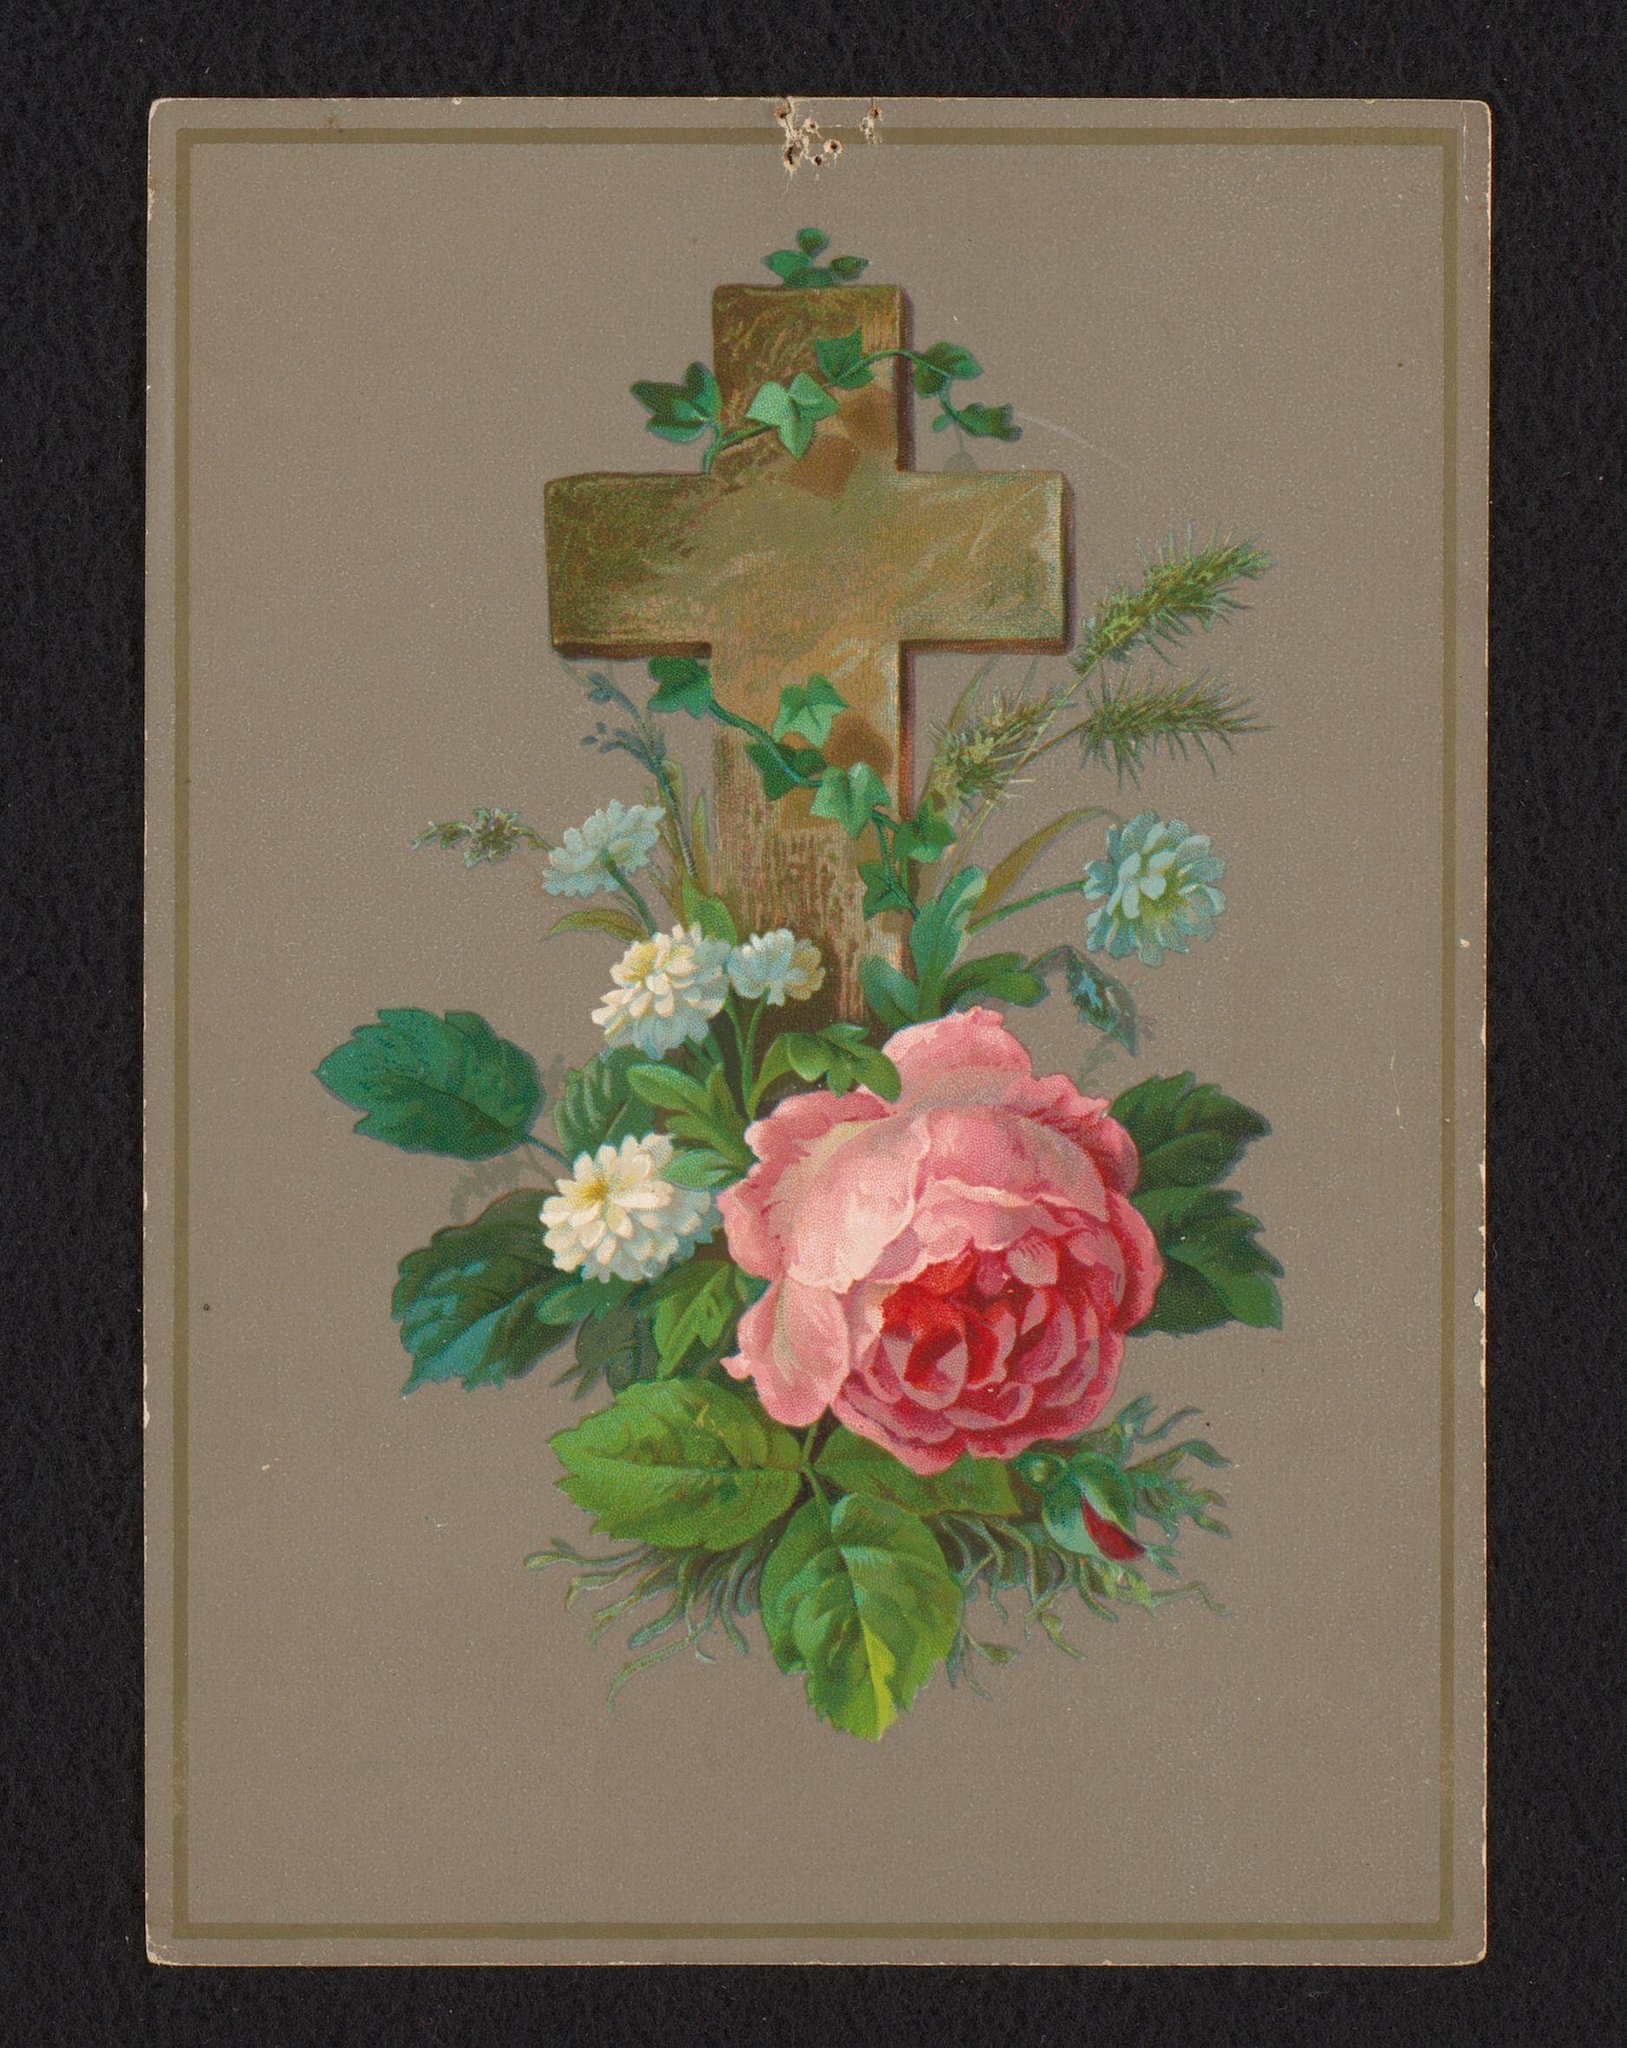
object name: memorial card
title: Herdenkingskaart met kruis, pioenroos en veldbloemen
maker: Anonymous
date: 1850-1950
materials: paper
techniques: chromolithography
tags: plants and herbs: peony, ex-libris, the cross ~ symbols of christ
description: Bij gebrek aan gegevens over de vervaardiger is voor de bepaling van de rechten van dit object gebruik gemaakt van de vervaardigingsdatum.